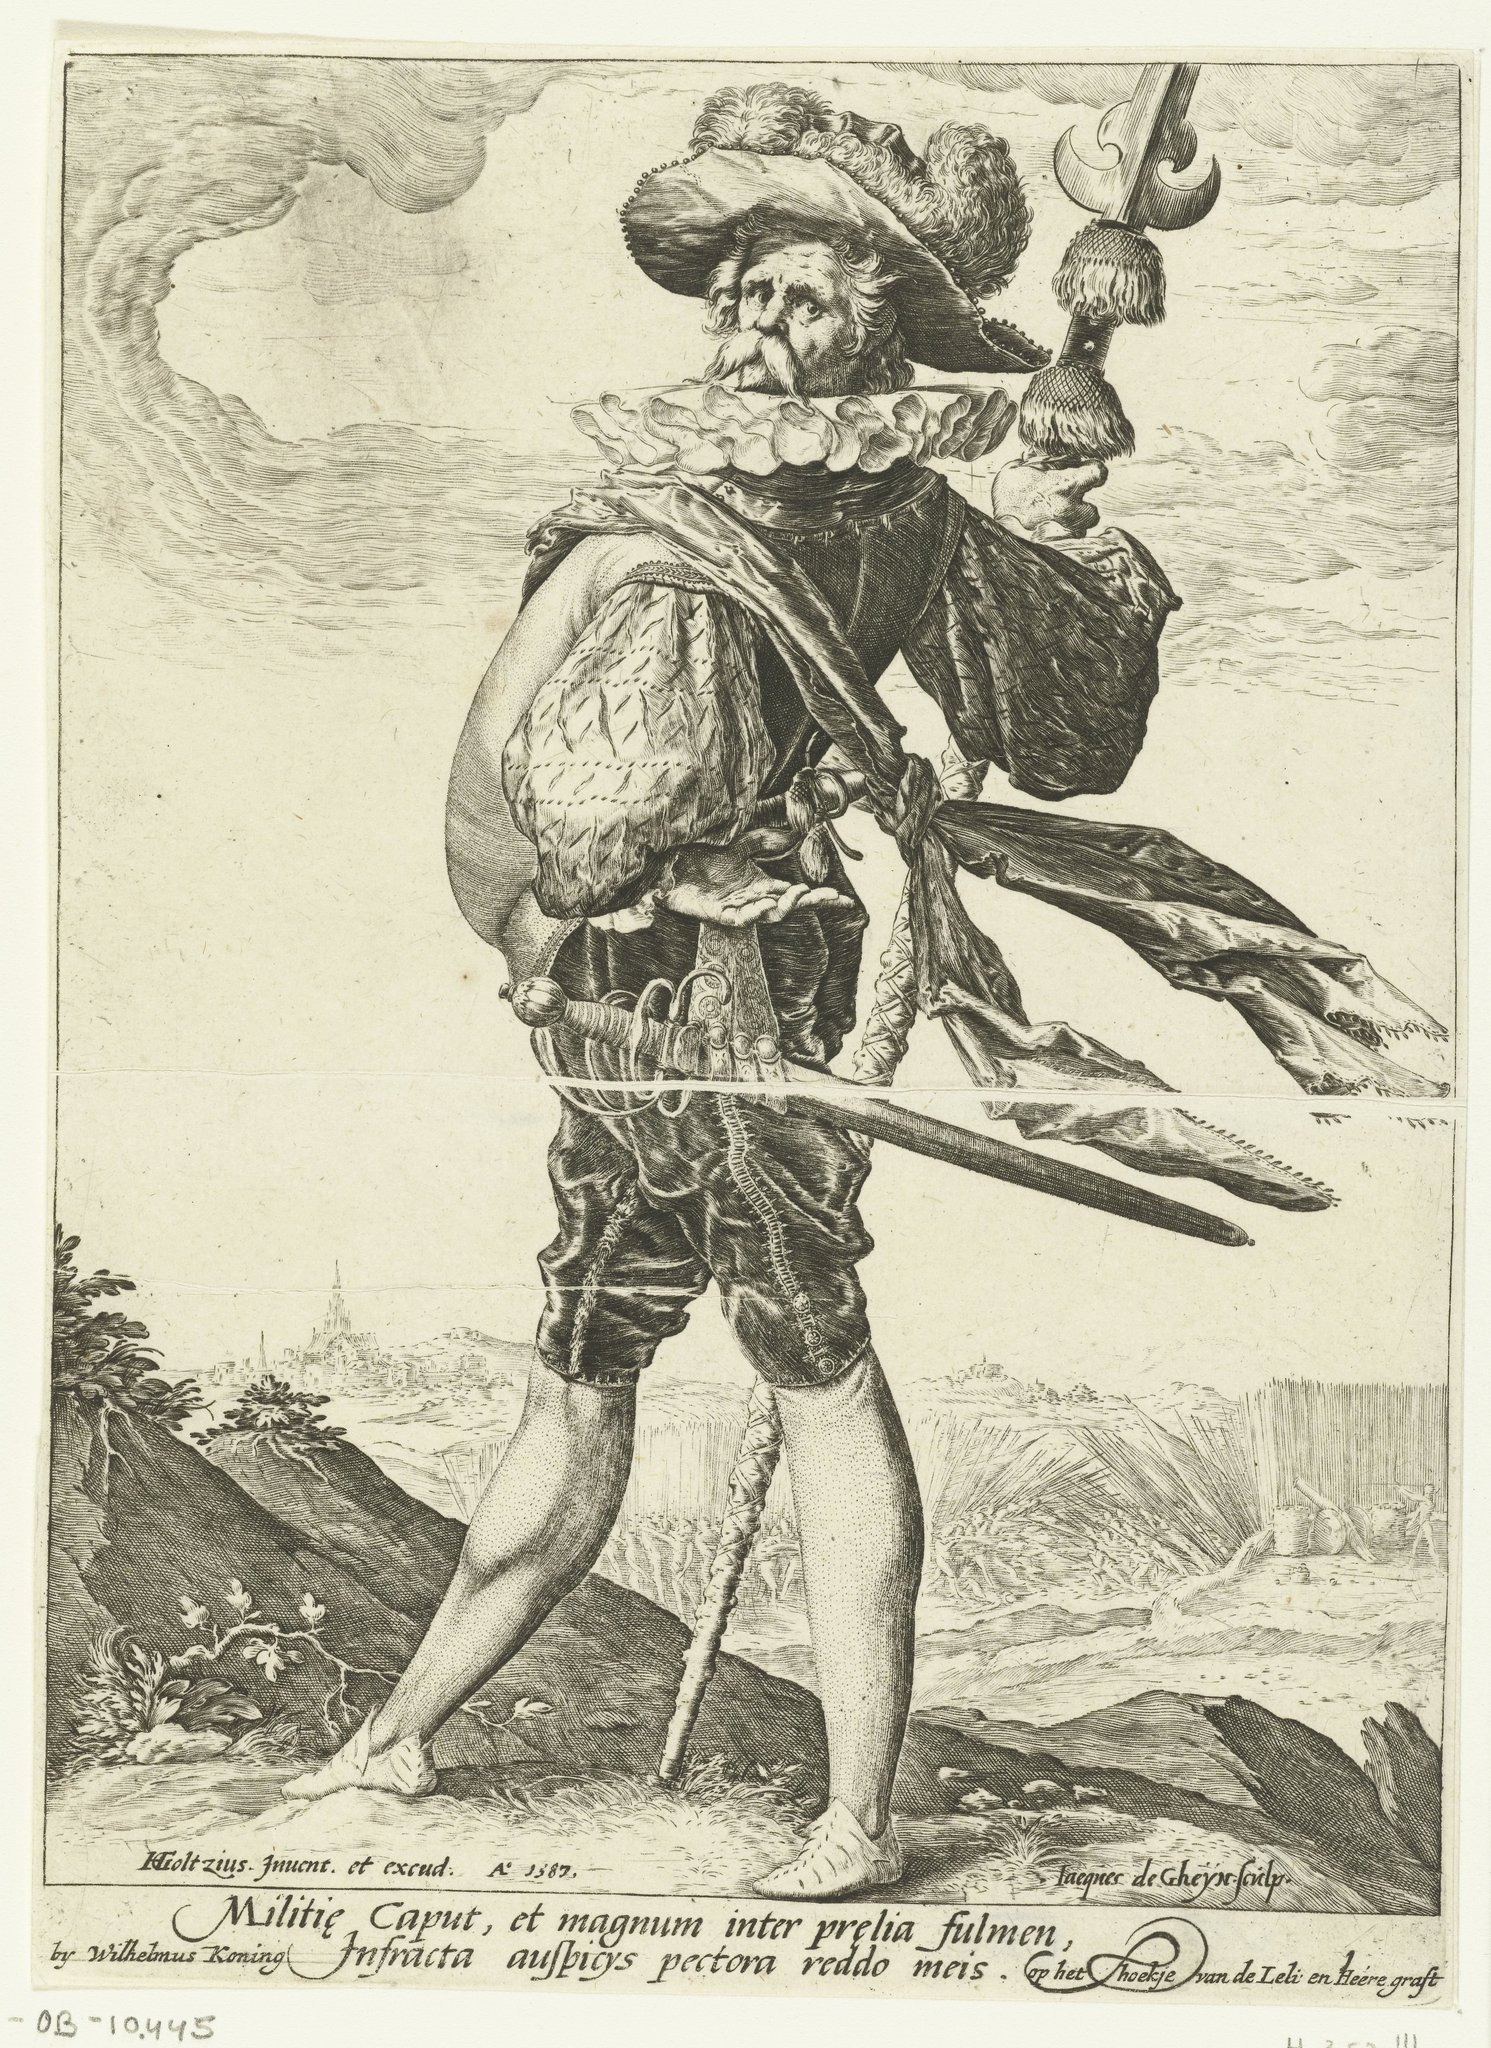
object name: print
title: Officieren en soldaten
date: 1587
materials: paper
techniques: engraving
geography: netherlands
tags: helved weapons, polearms (for striking, hacking, thrusting), battle, officer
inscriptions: collector's mark: Lugt 2228a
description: Een man in militaire uitdossing (een kolonel), ten voeten uit, op de linkerzijde gezien, een zwaard aan zijn gordel, een stokwapen (partizaan) in zijn rechterhand. Op de achtergrond een heuvelachtig landschap waarin een slag plaatsvindt. Onder de voorstelling twee regels tekst in Latijn. Deze prent is onderdeel van een serie van 12 prenten van militairen, ten voeten uit weergegeven tegen een landschappelijke achtergrond waarin krijgshandelingen verricht worden, en met een tweeregelig Latijns onderschrift.